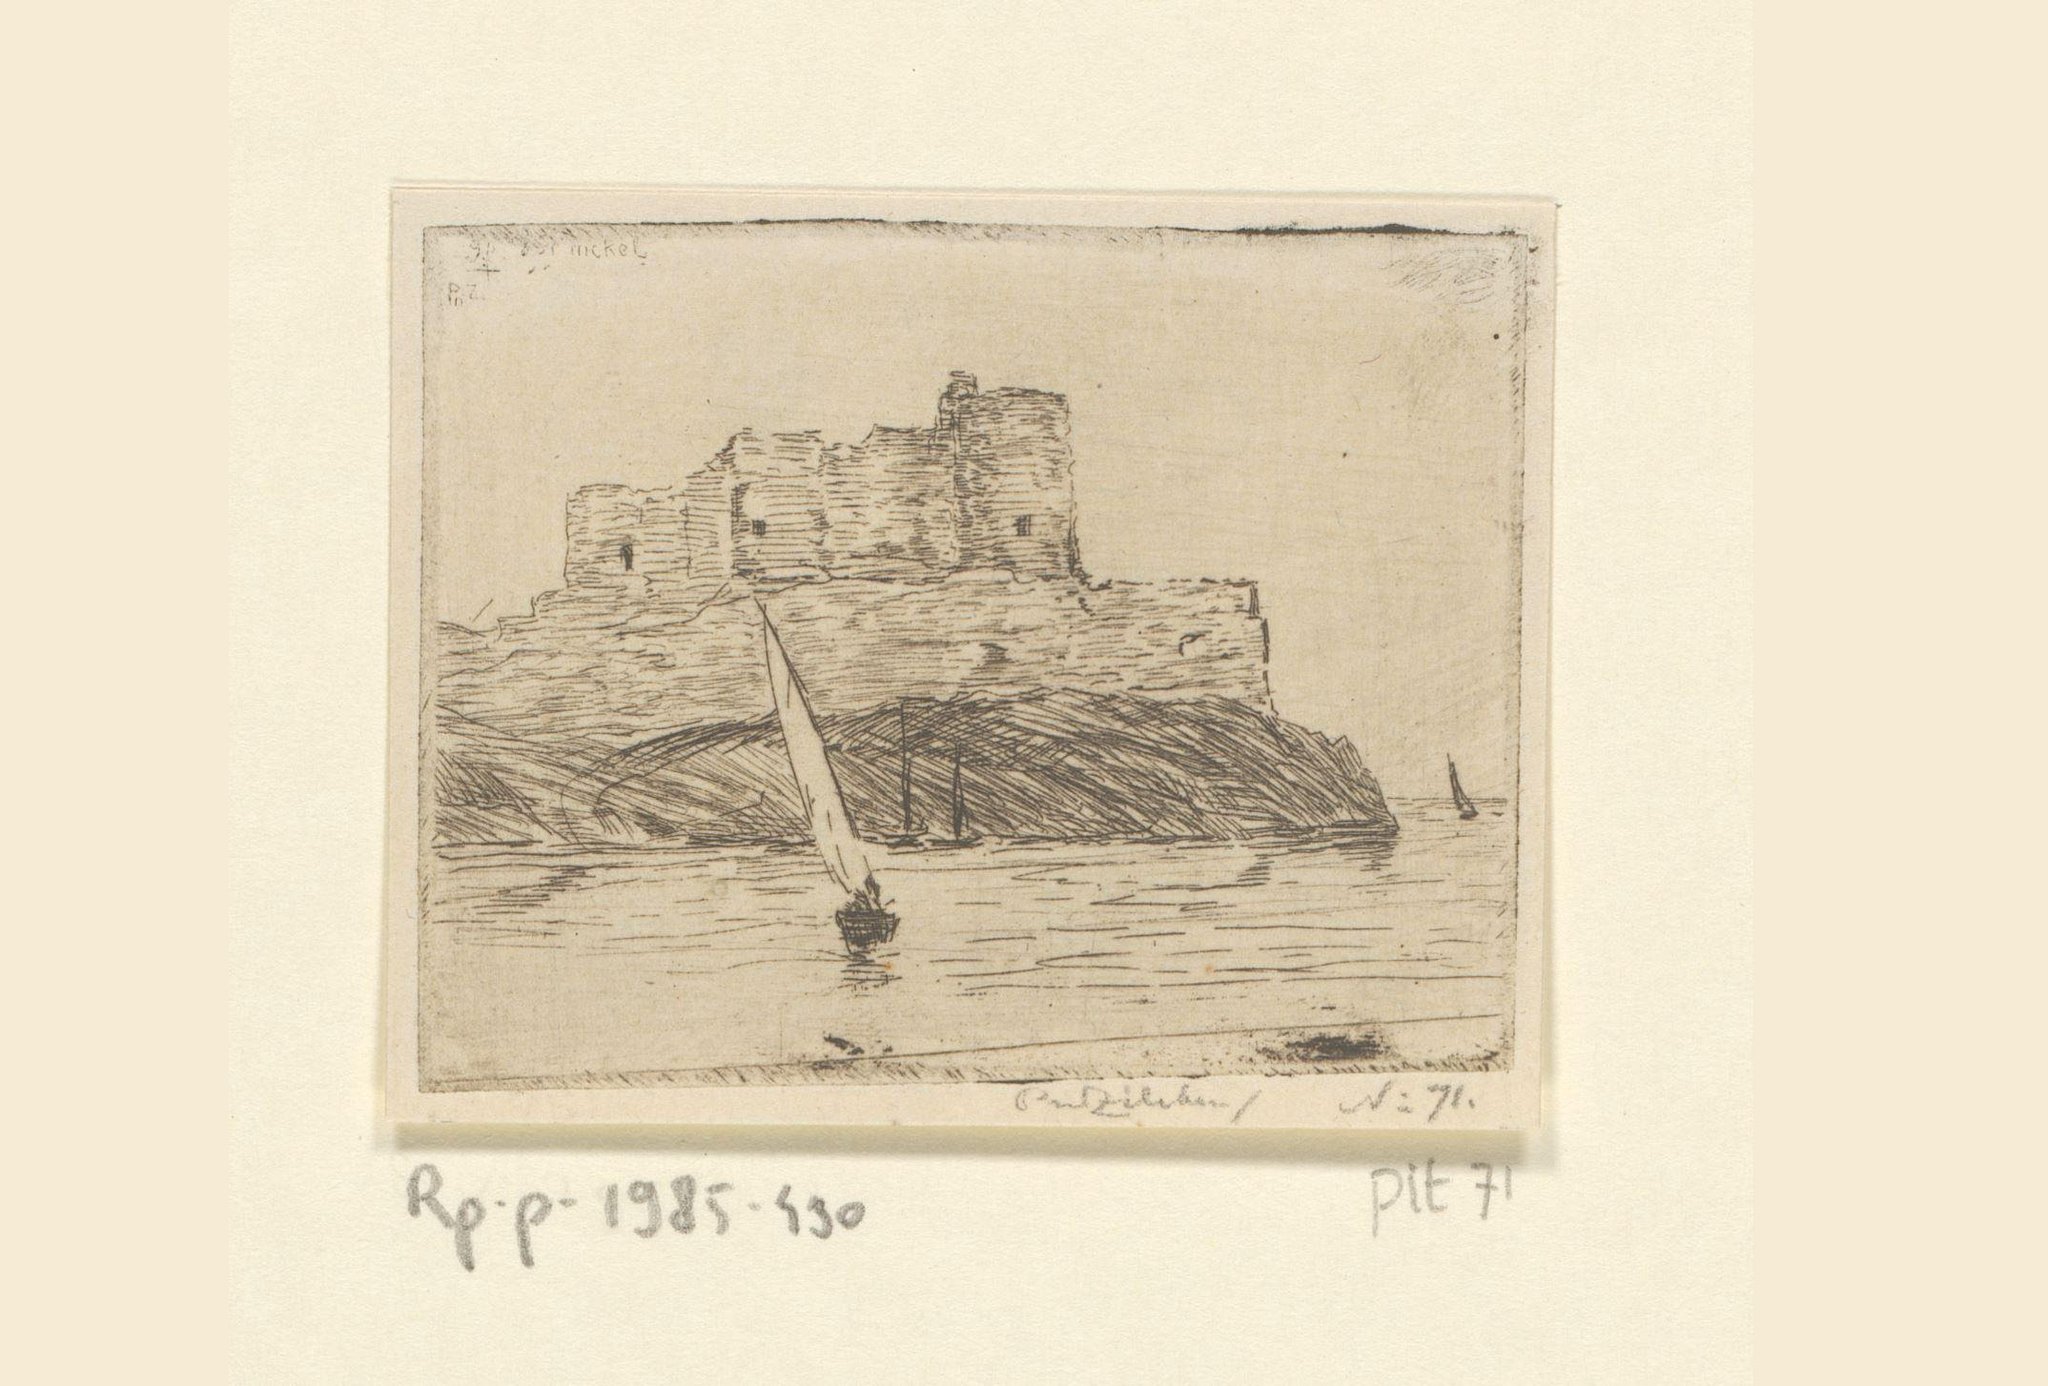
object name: print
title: Gezicht op Château d'If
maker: philip zilcken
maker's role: draughtsman, painter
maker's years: 1857-1930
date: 1867-1890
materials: paper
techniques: etching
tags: fortress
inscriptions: collector's mark: Lugt 2228, collector's mark: Lugt 2760